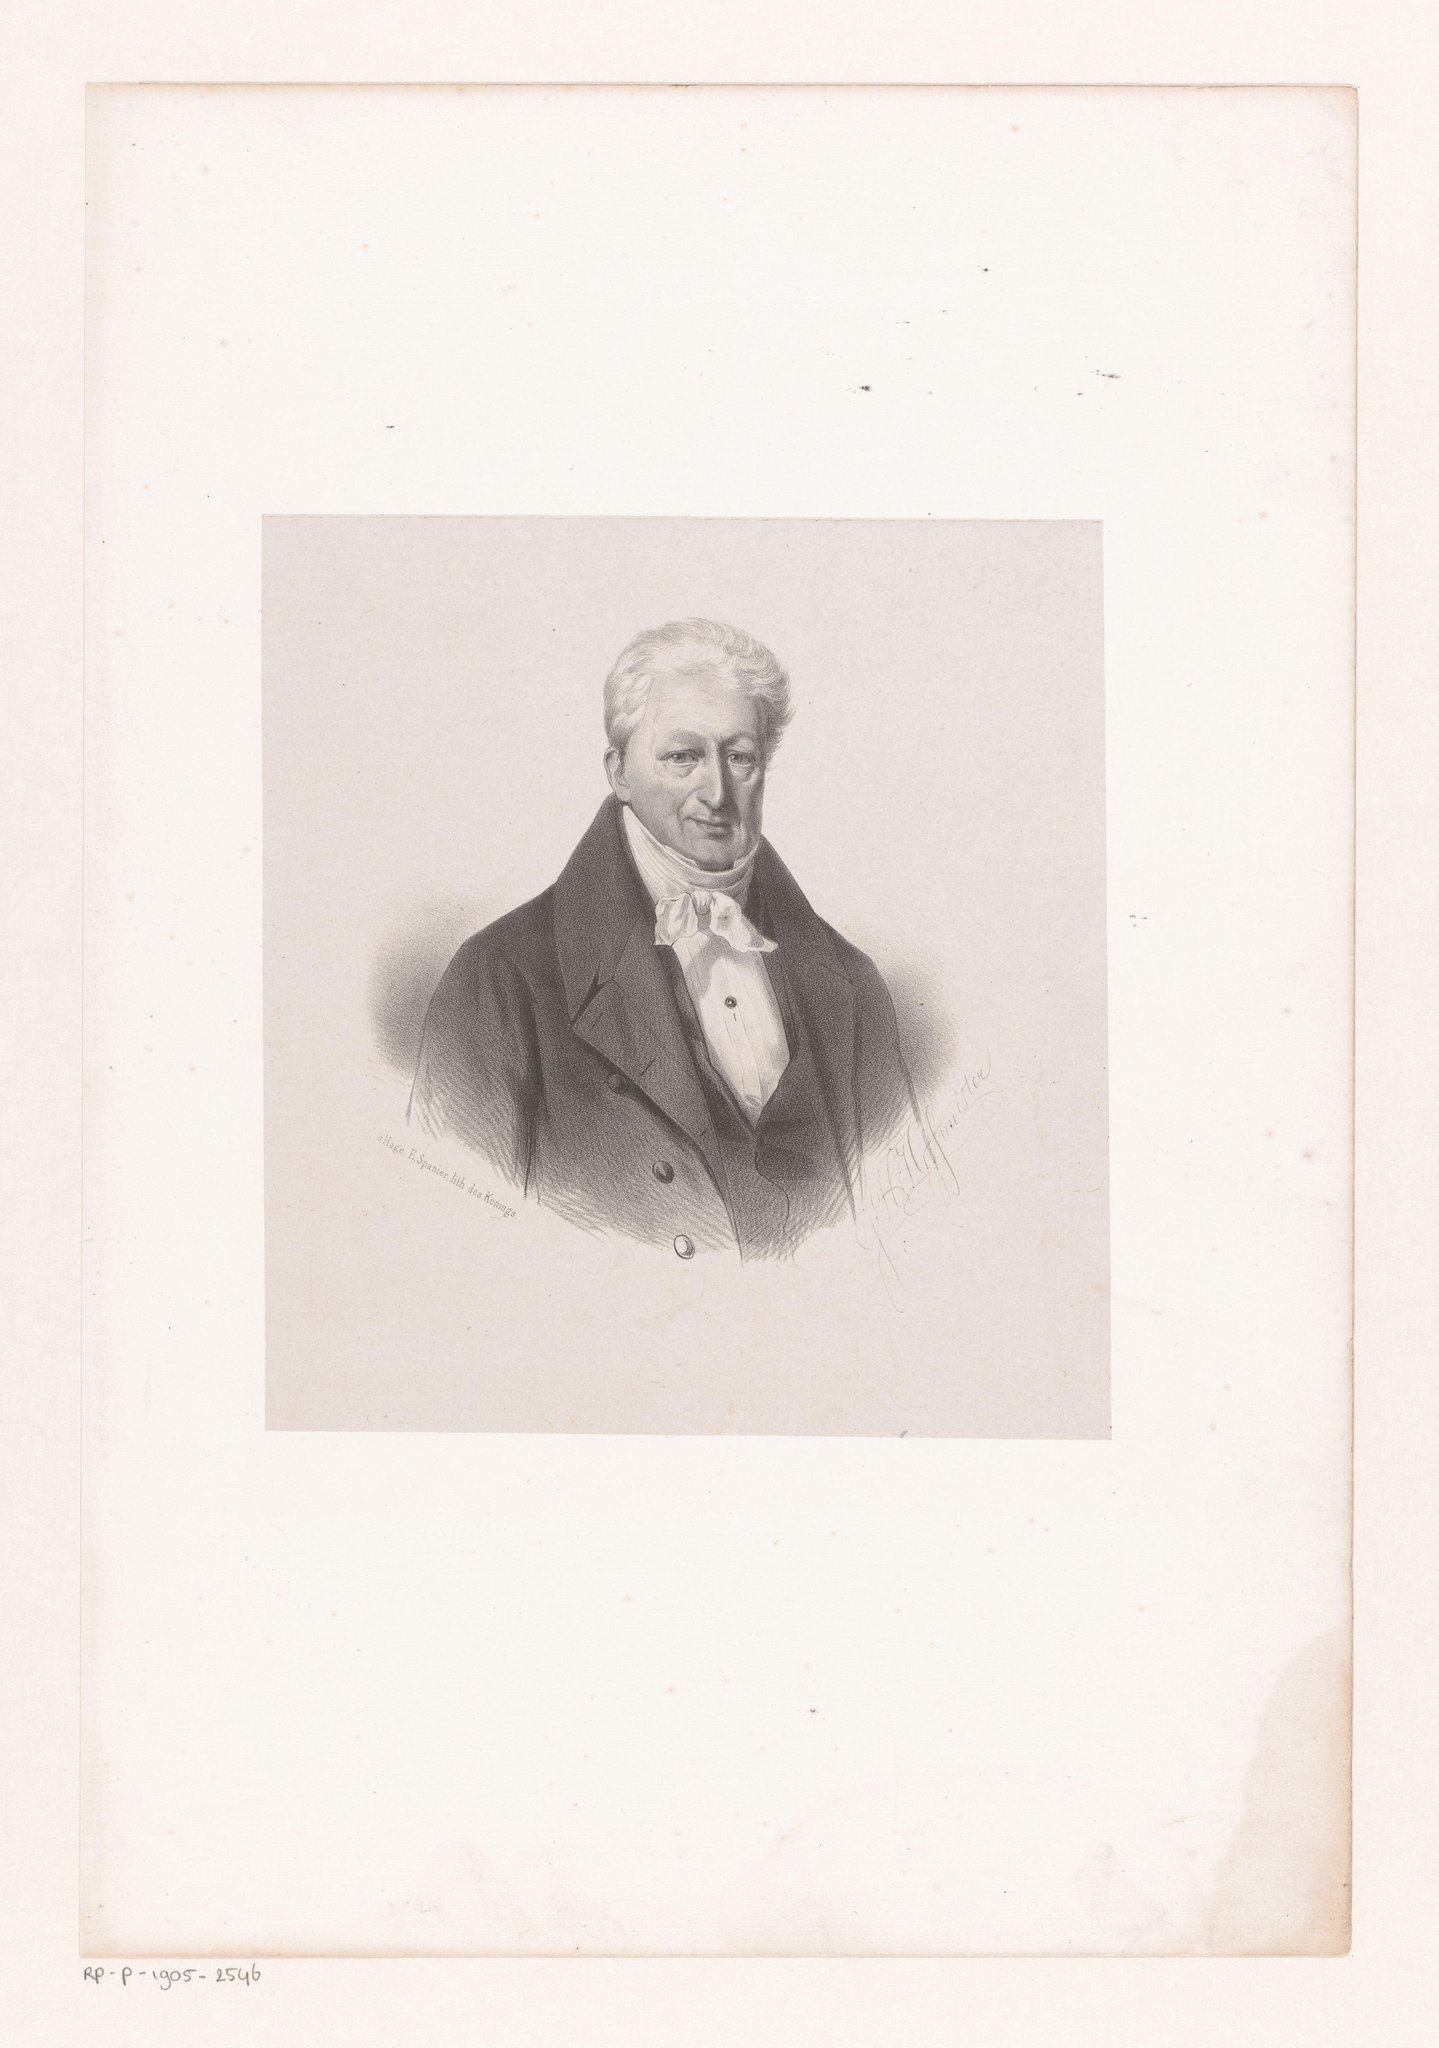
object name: print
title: Portret van een onbekende man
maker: johan hendrik hoffmeister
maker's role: print maker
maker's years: 1823-1904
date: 1851-1883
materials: paper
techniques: lithograph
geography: the hague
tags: historical persons (+ (full) bust portrait)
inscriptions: collector's mark: Lugt 2228